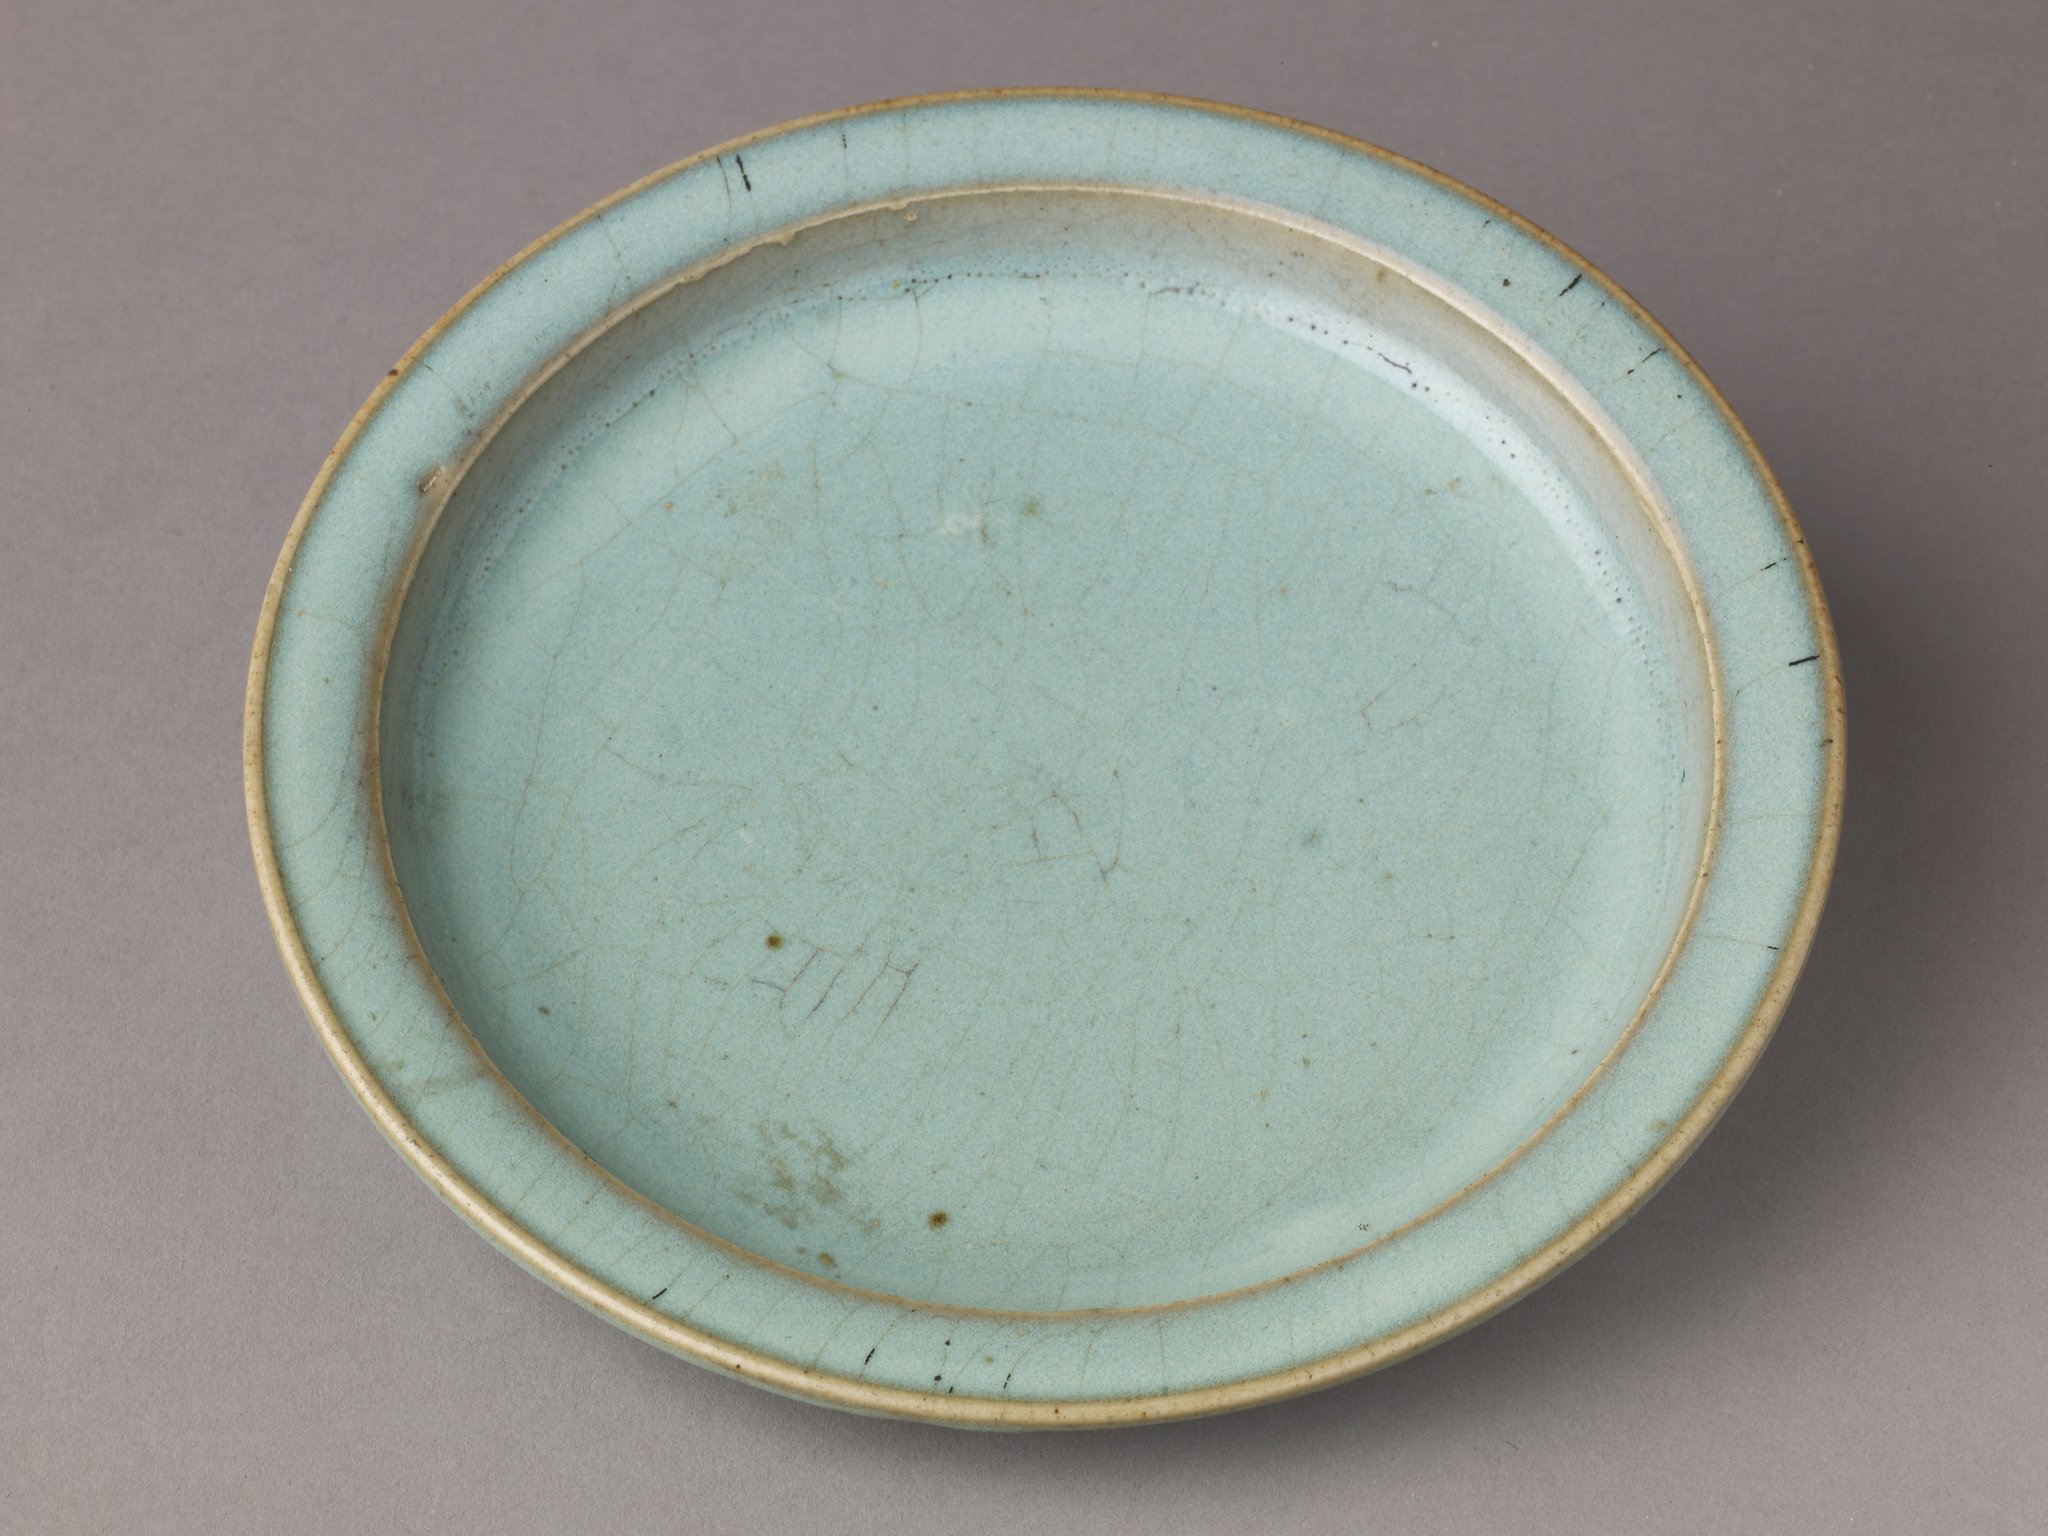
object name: plate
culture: chinese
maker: chinese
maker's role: artist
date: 1101-1300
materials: glaze, stoneware